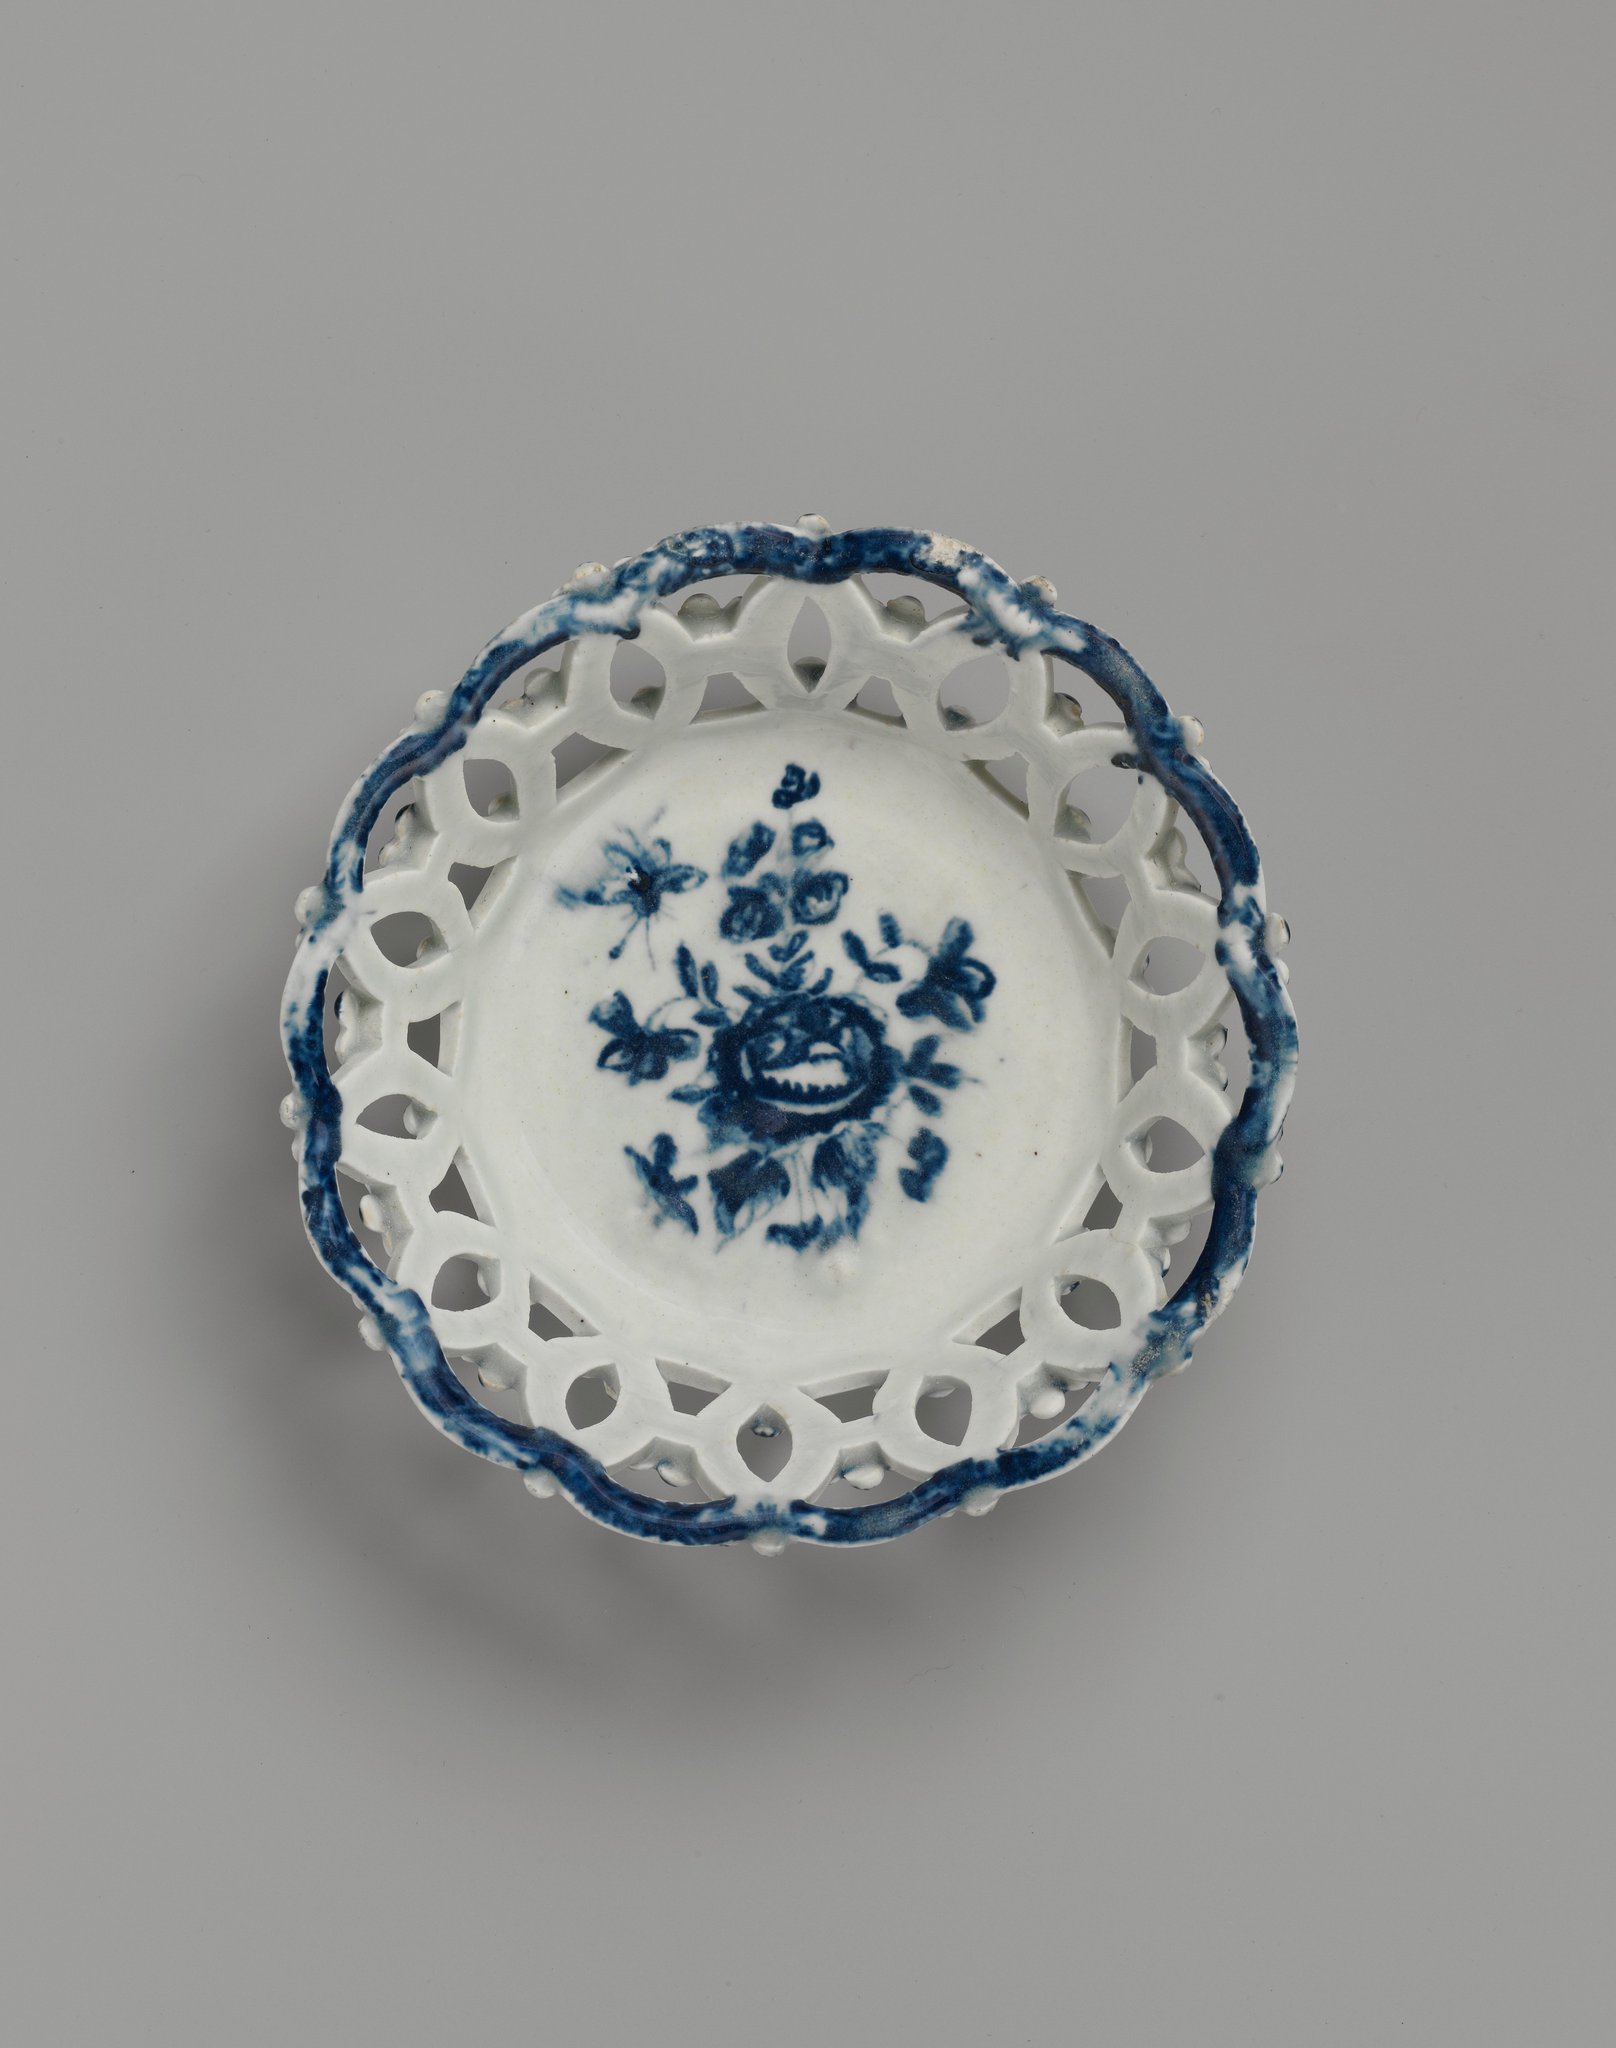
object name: basket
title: Openwork fruit basket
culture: american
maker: american china manufactory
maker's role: manufacturer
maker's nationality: american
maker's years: 1770-1772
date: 1770-1772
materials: soft paste porcelain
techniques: underglaze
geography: united states